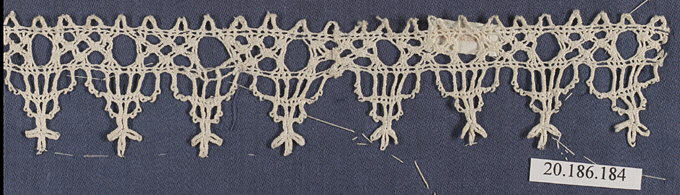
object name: edging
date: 1601-1700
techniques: lace